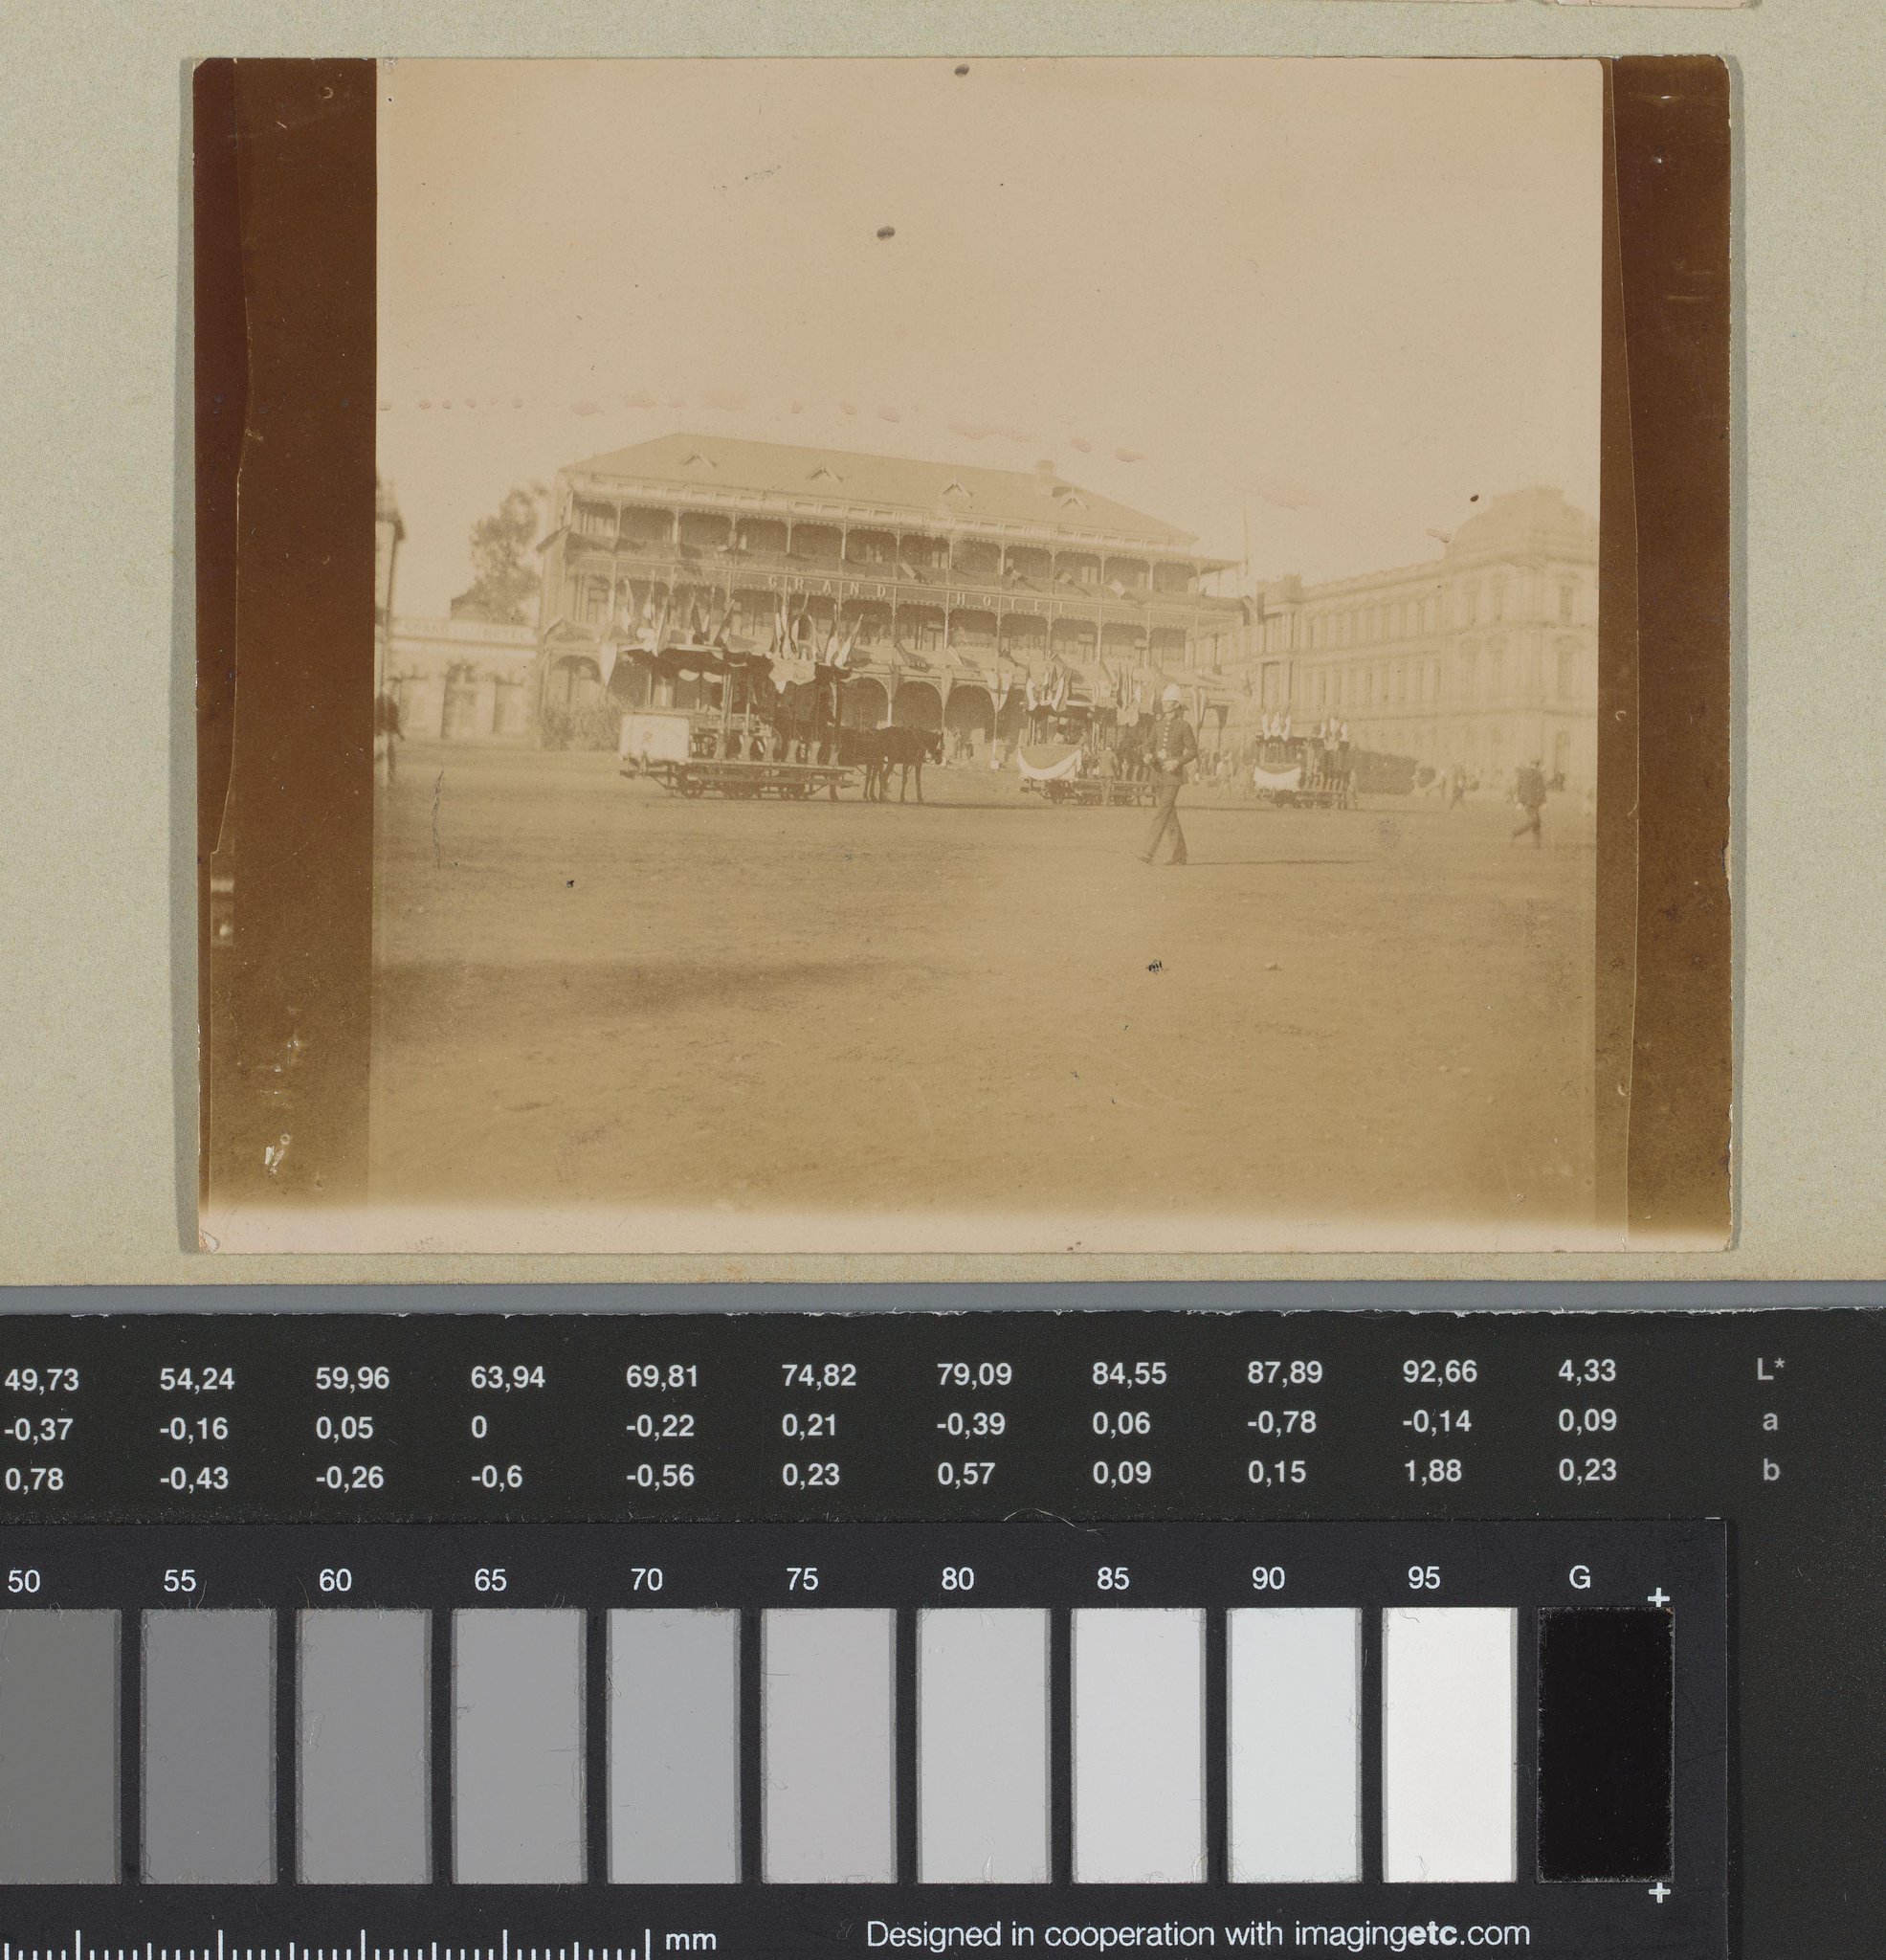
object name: photograph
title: Parade ter ere van de inhuldiging van president Kruger op het Kerkplein in Pretoria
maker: Anonymous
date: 1898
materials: paper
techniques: gelatin silver print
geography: pretoria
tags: ceremonial procession, parade, pageant ~ installation of a ruler, square, place, circus, etc.